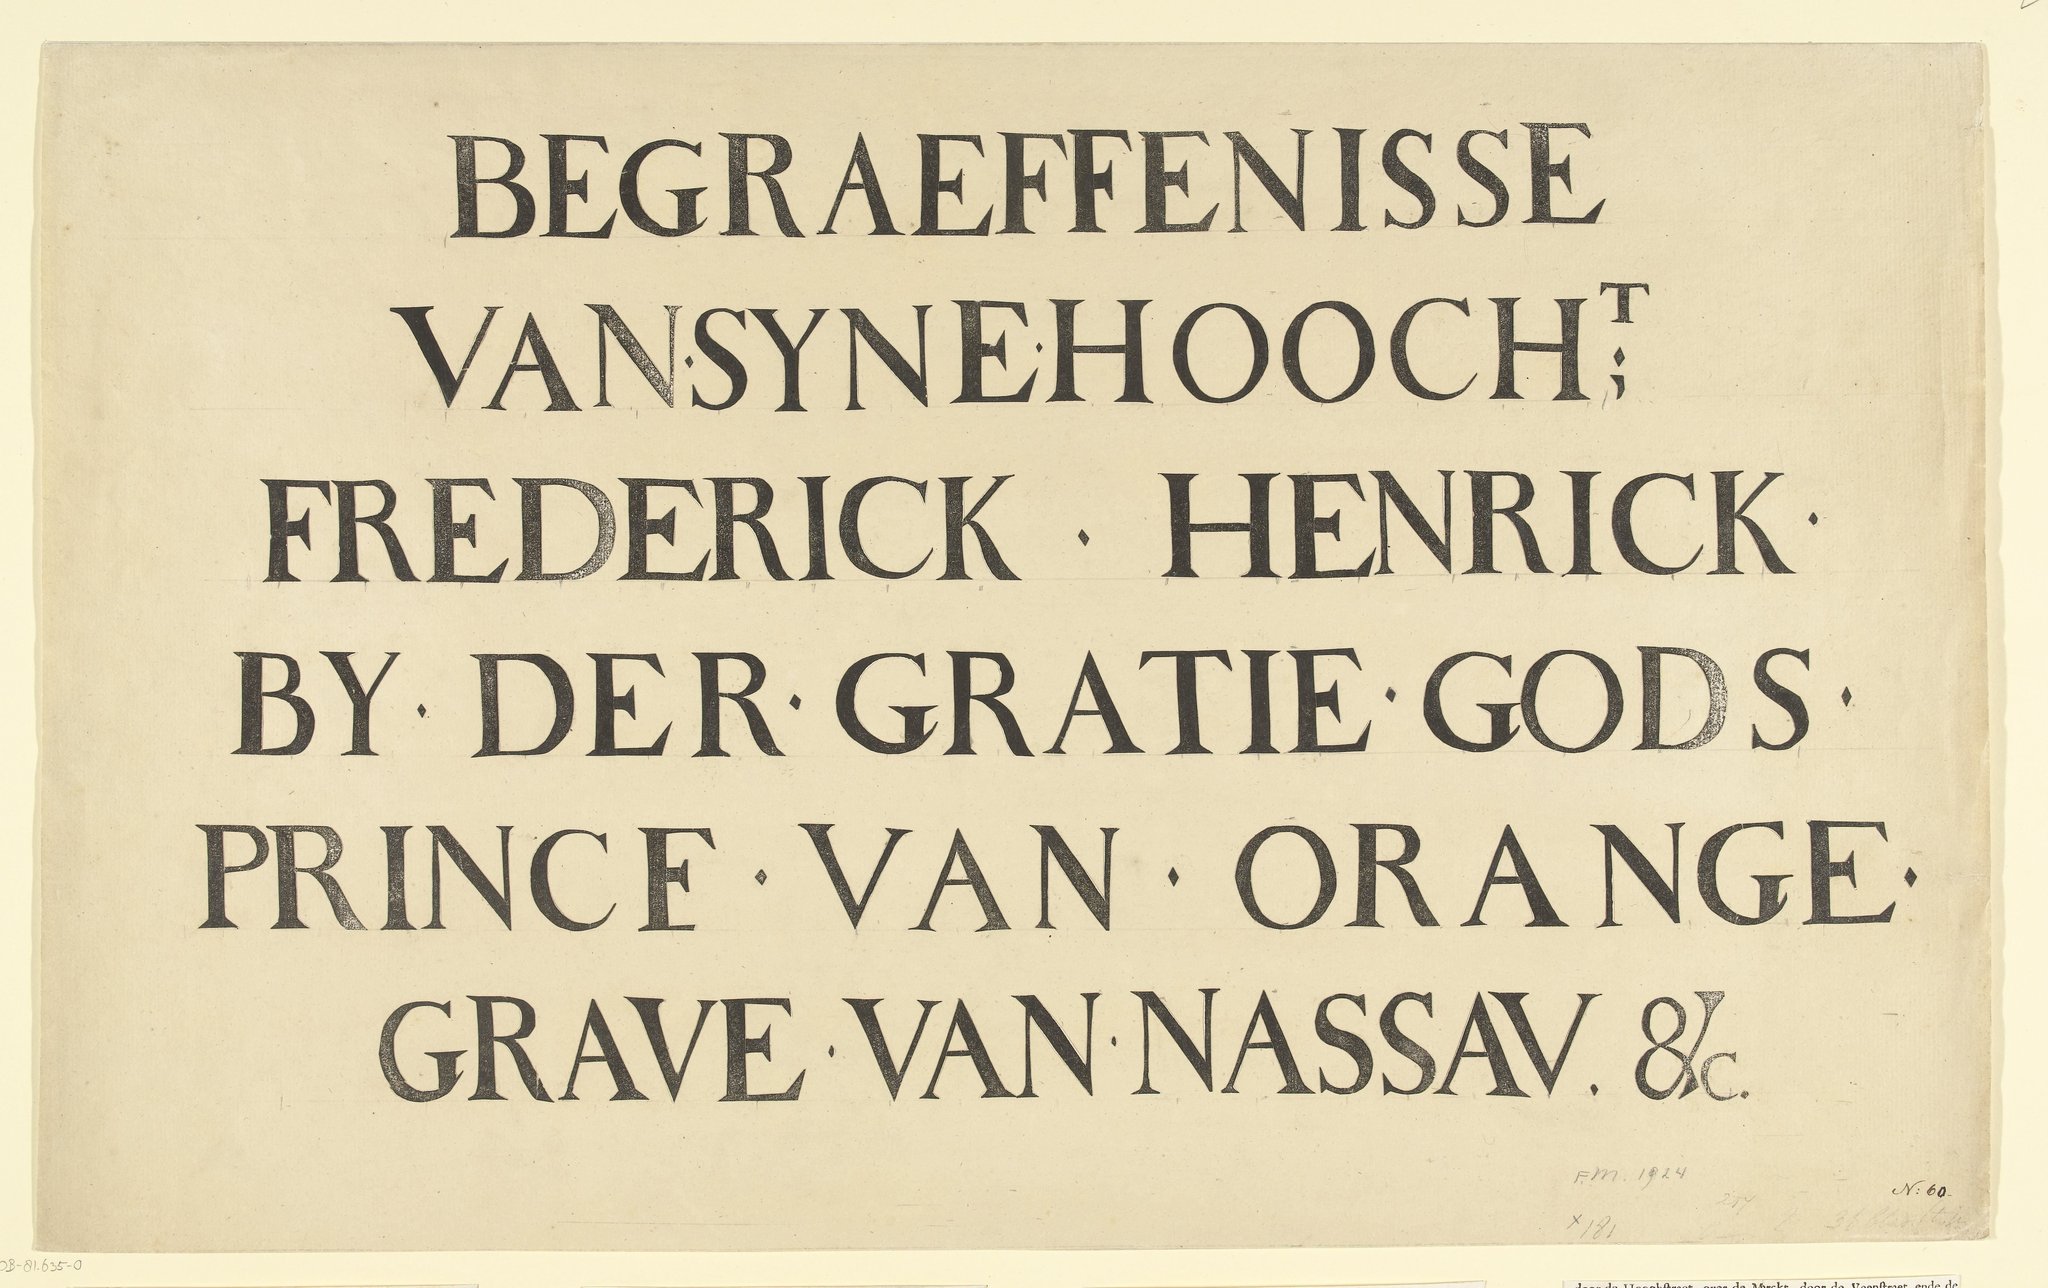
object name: text sheet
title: De begrafenisstoet van stadhouder Frederik Hendrik te 's-Gravenhage in 1647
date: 1647-1651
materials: paper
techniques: woodcut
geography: the hague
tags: frederick henry (prince of orange), the hague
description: De begrafenisstoet van stadhouder Frederik Hendrik te 's-Gravenhage op 10 mei 1647. Tekstblad met de titel in grote letters in 6 rijen. Onderdeel van een serie van 30 platen en 20 tekstbladen, bedoeld om aan elkaar geplakt te worden.